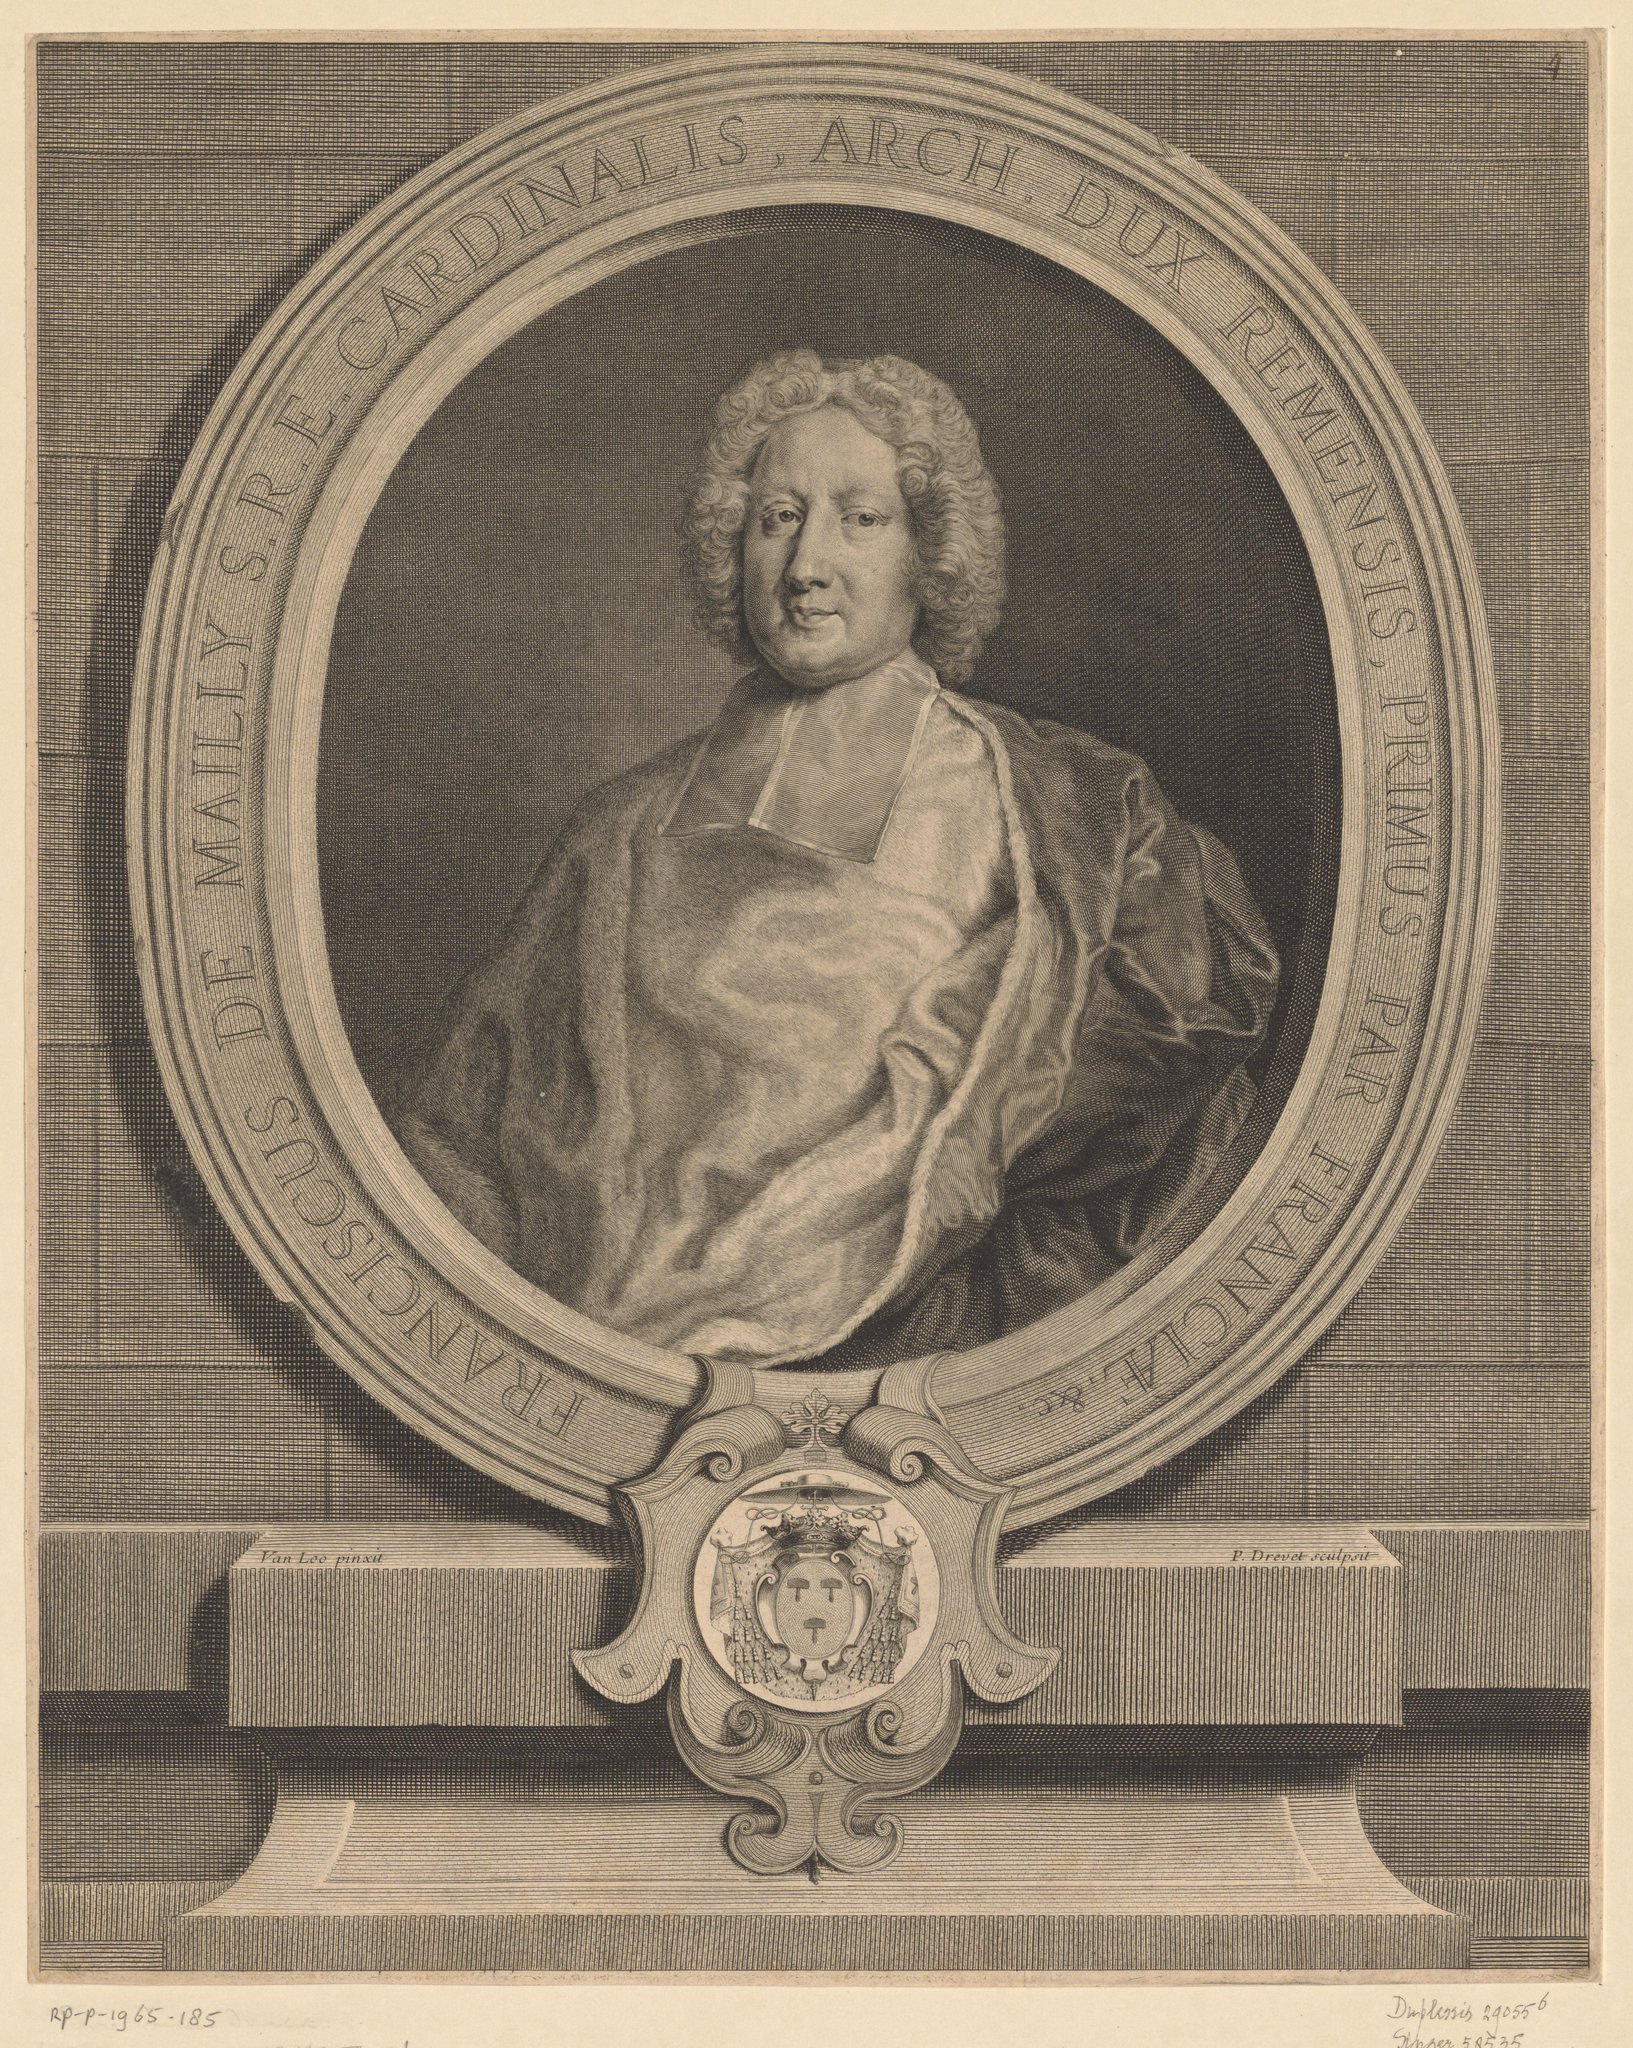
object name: print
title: Portret van François de Mailly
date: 1719-1721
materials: paper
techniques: engraving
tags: ornament ~ medallion, cardinal, historical persons, armorial bearing, heraldry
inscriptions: number: ‘4’, collector's mark: Lugt 2228